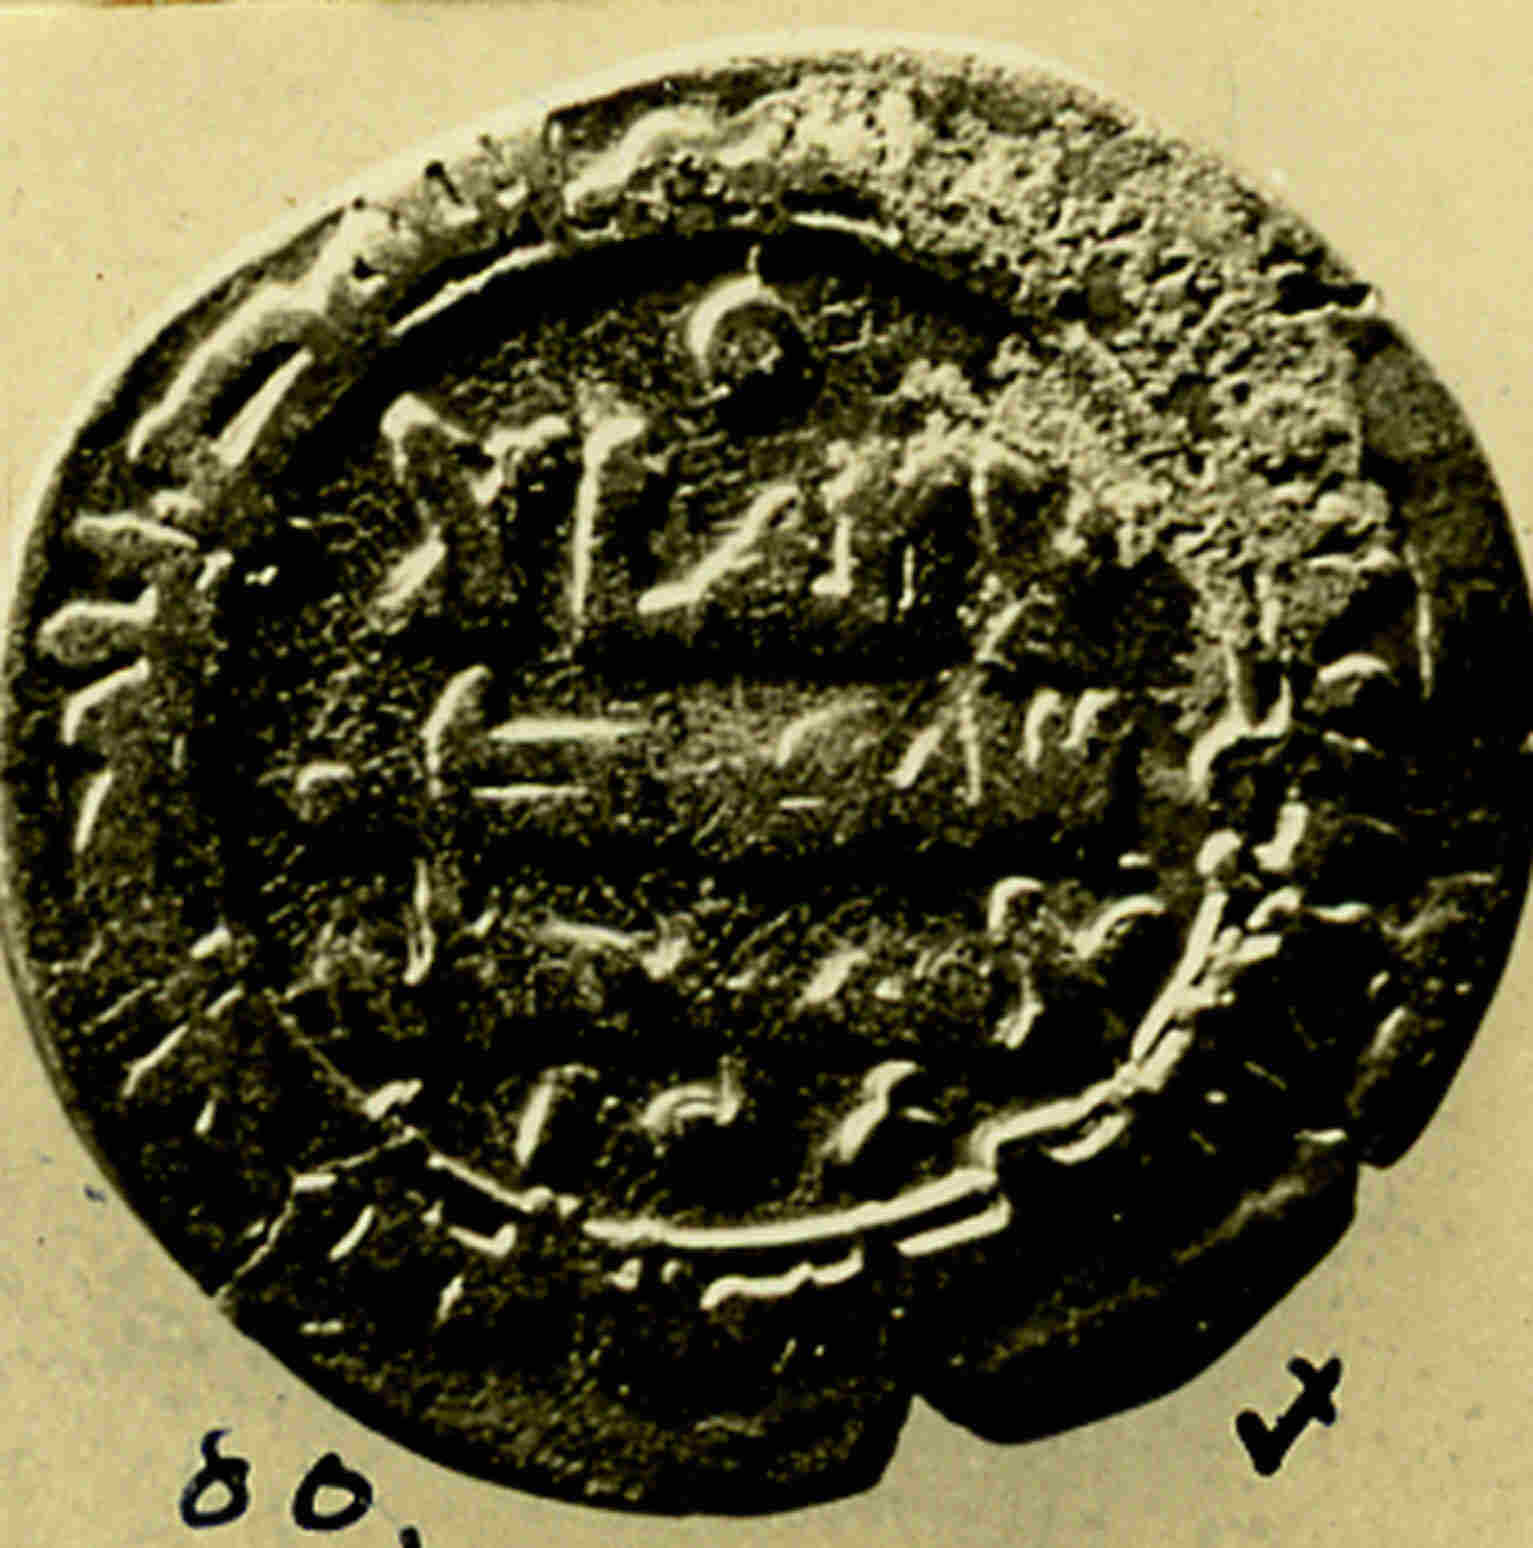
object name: coin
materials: silver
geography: al-shash